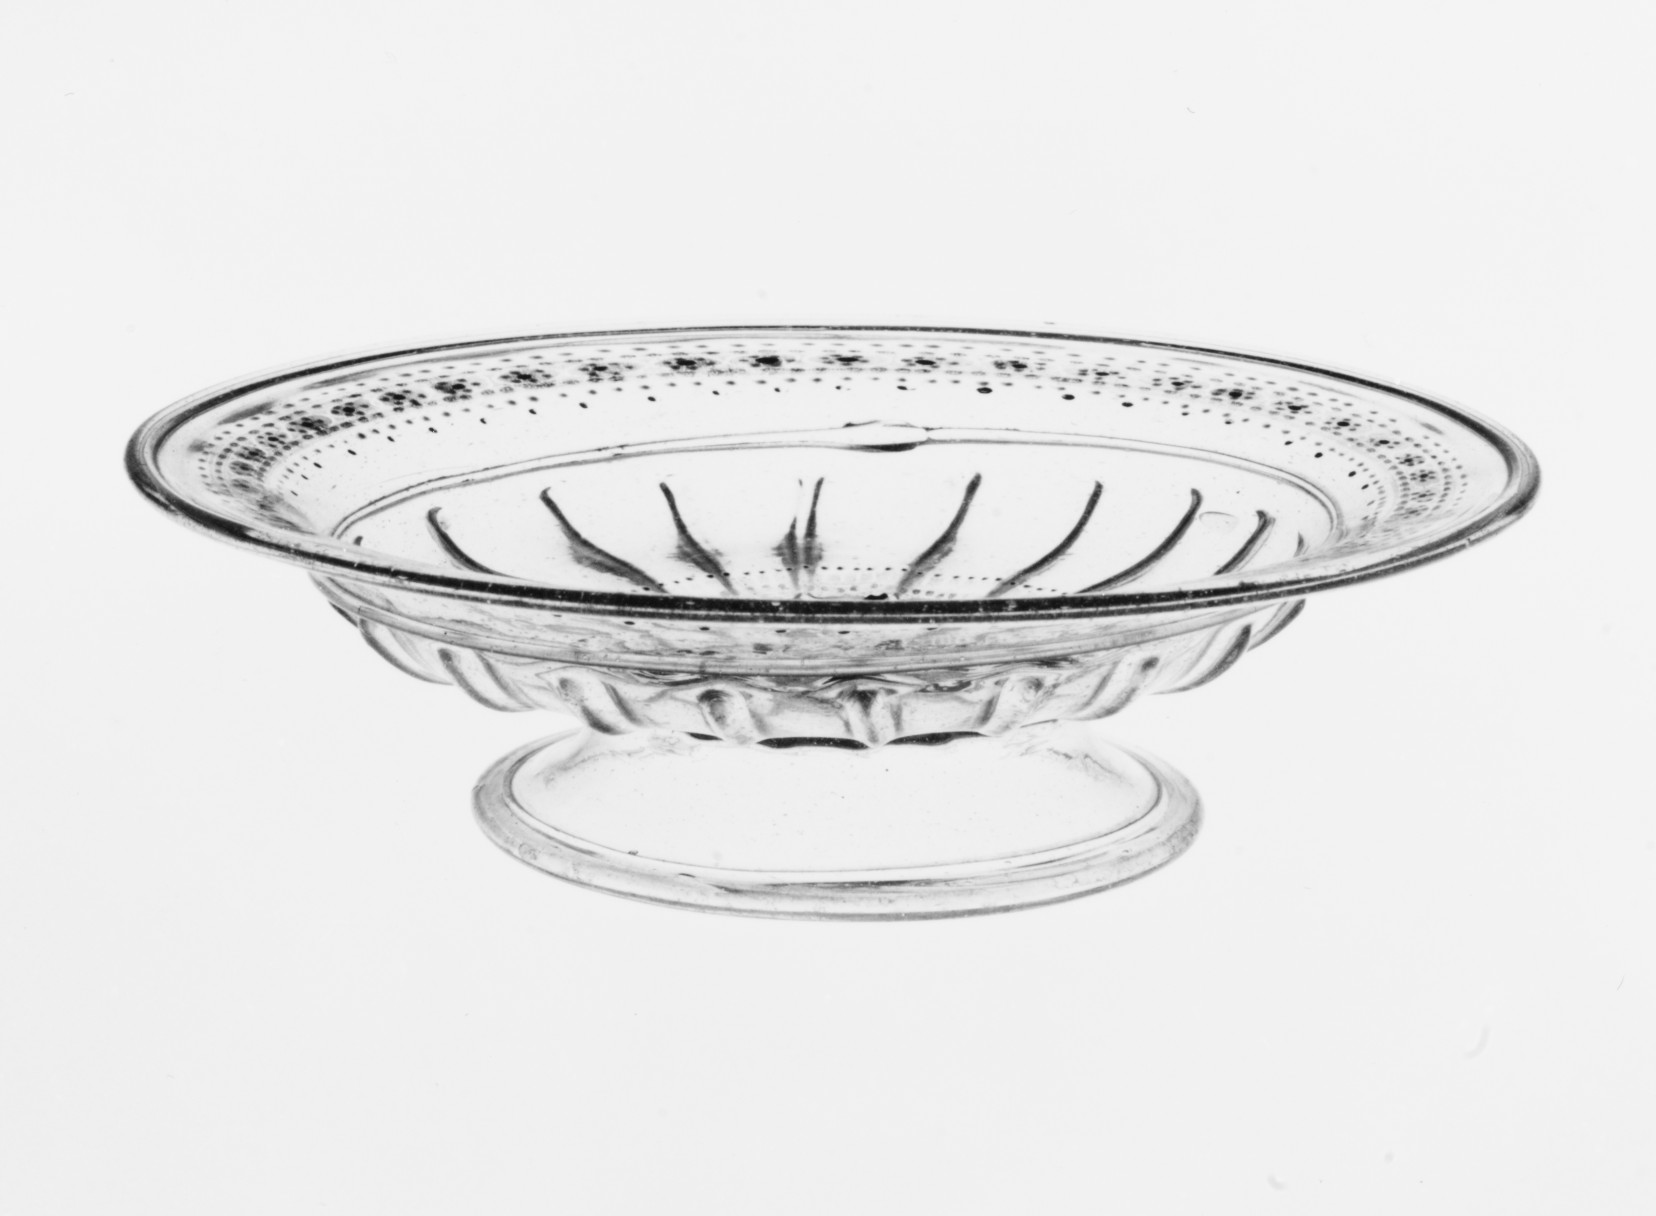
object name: tazza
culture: italian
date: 1500-1525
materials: gilt, glass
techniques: glassblowing, enamel, molding